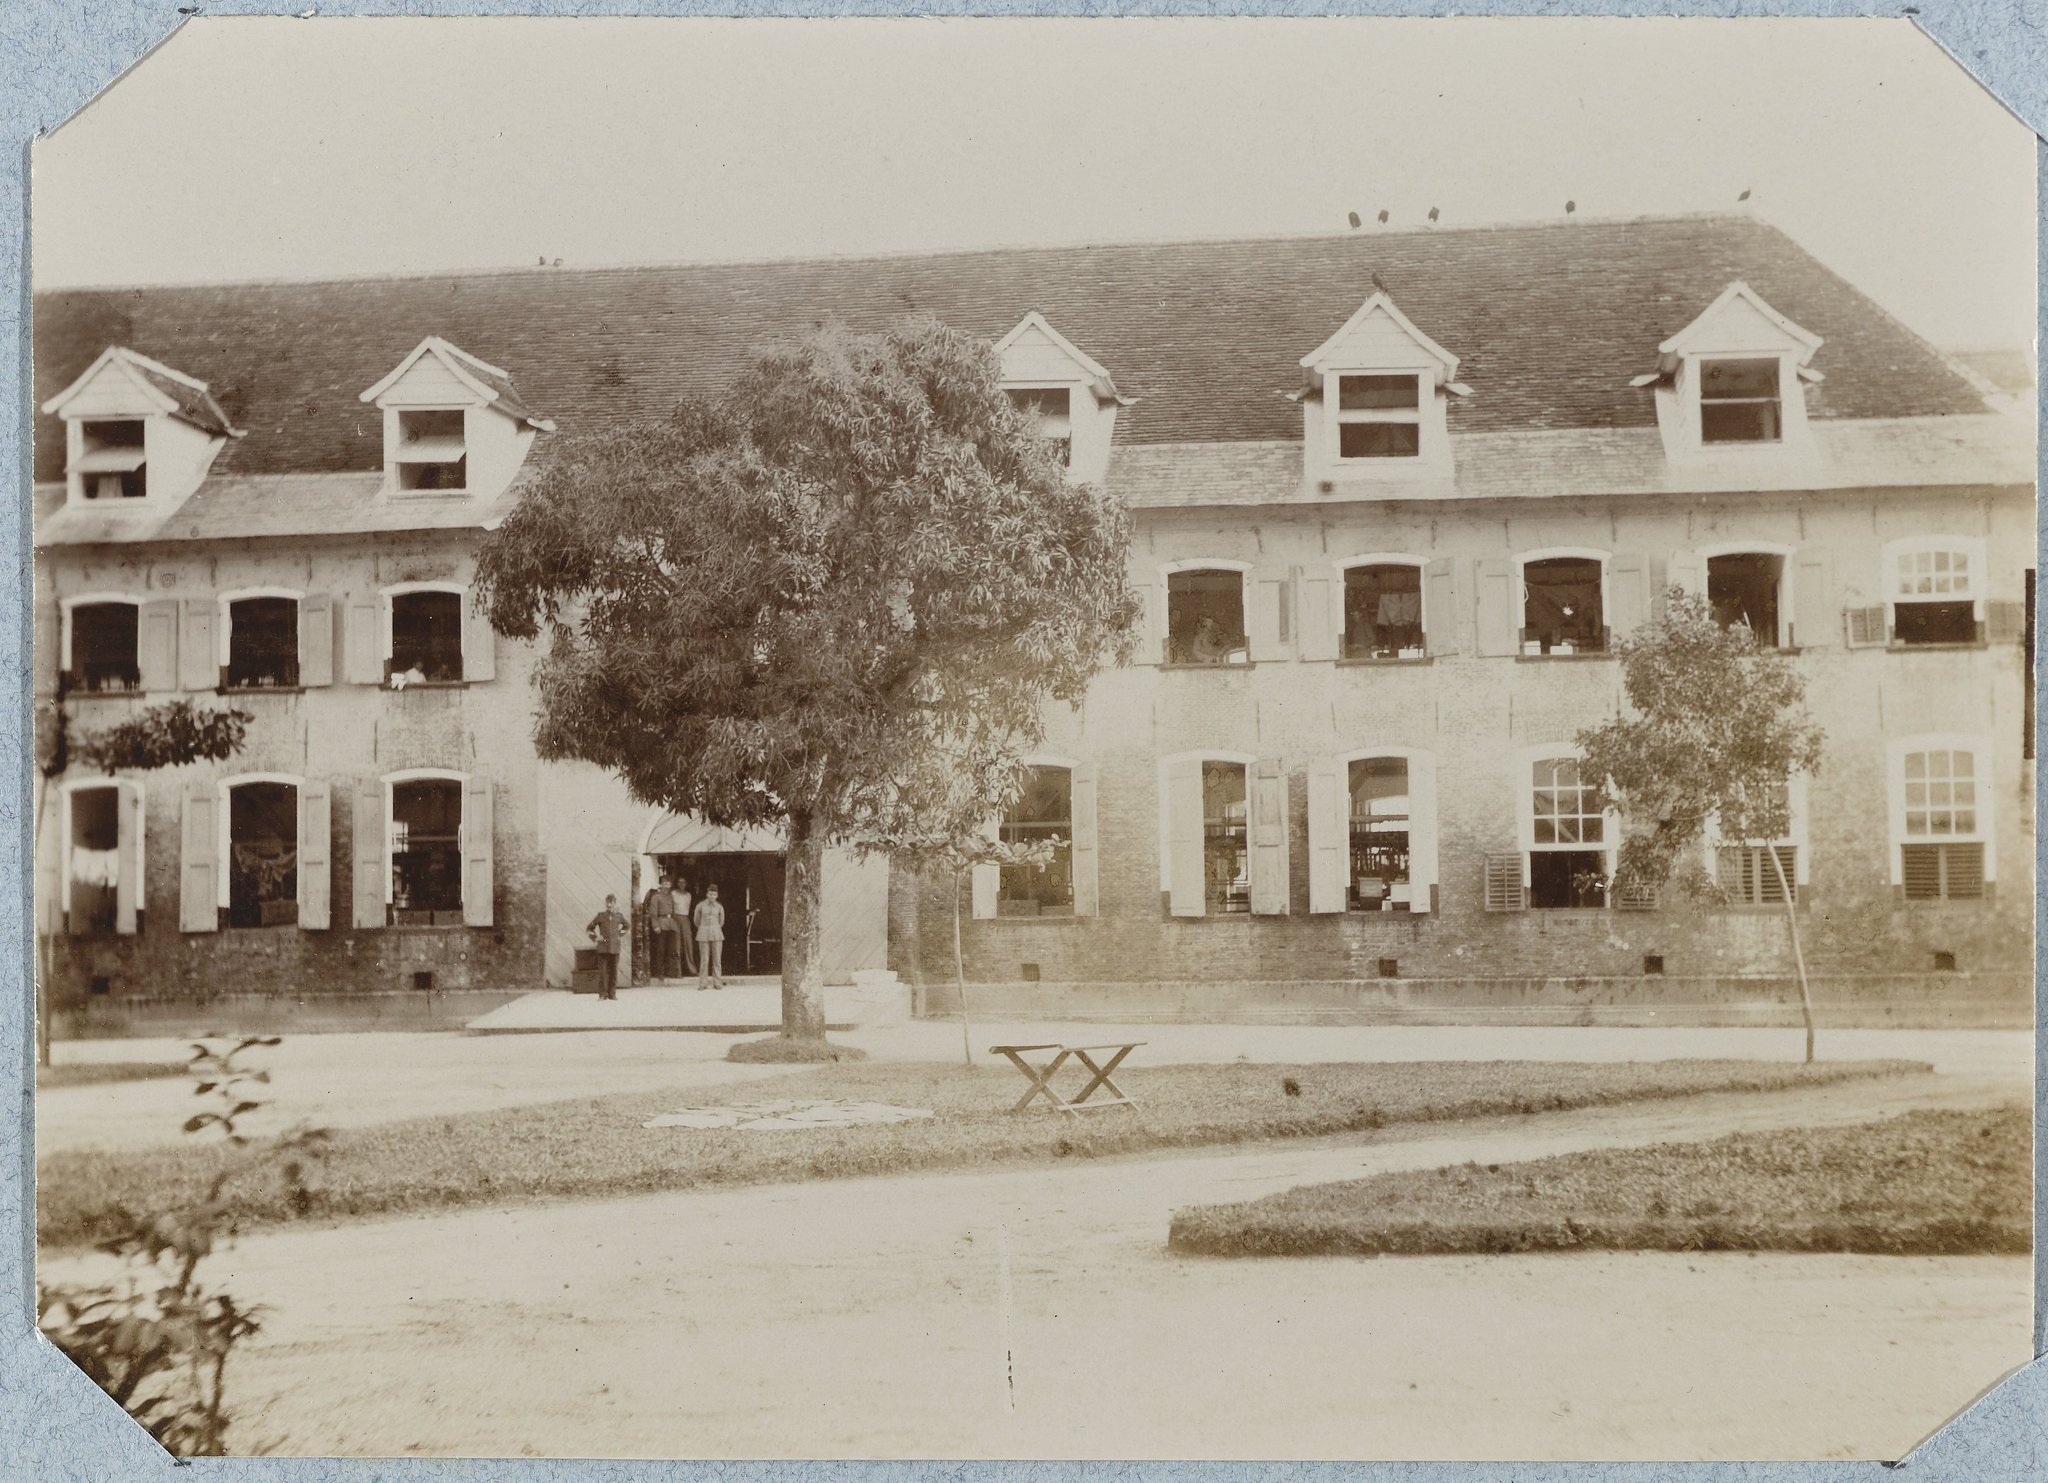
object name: photograph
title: De Kazerne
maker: théodore van lelyveld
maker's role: painter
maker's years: 1867-1954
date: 1896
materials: photographic support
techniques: collodion silver print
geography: suriname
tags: garrison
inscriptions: inscription: ‘De Kazerne’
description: De kazerne in Fort Zeelandia te Paramaribo. Bij de ingang staat een groep militairen. Fotoafdruk in een fotoalbum van Théodore van Lelyveld over Suriname uit 1895-1898.